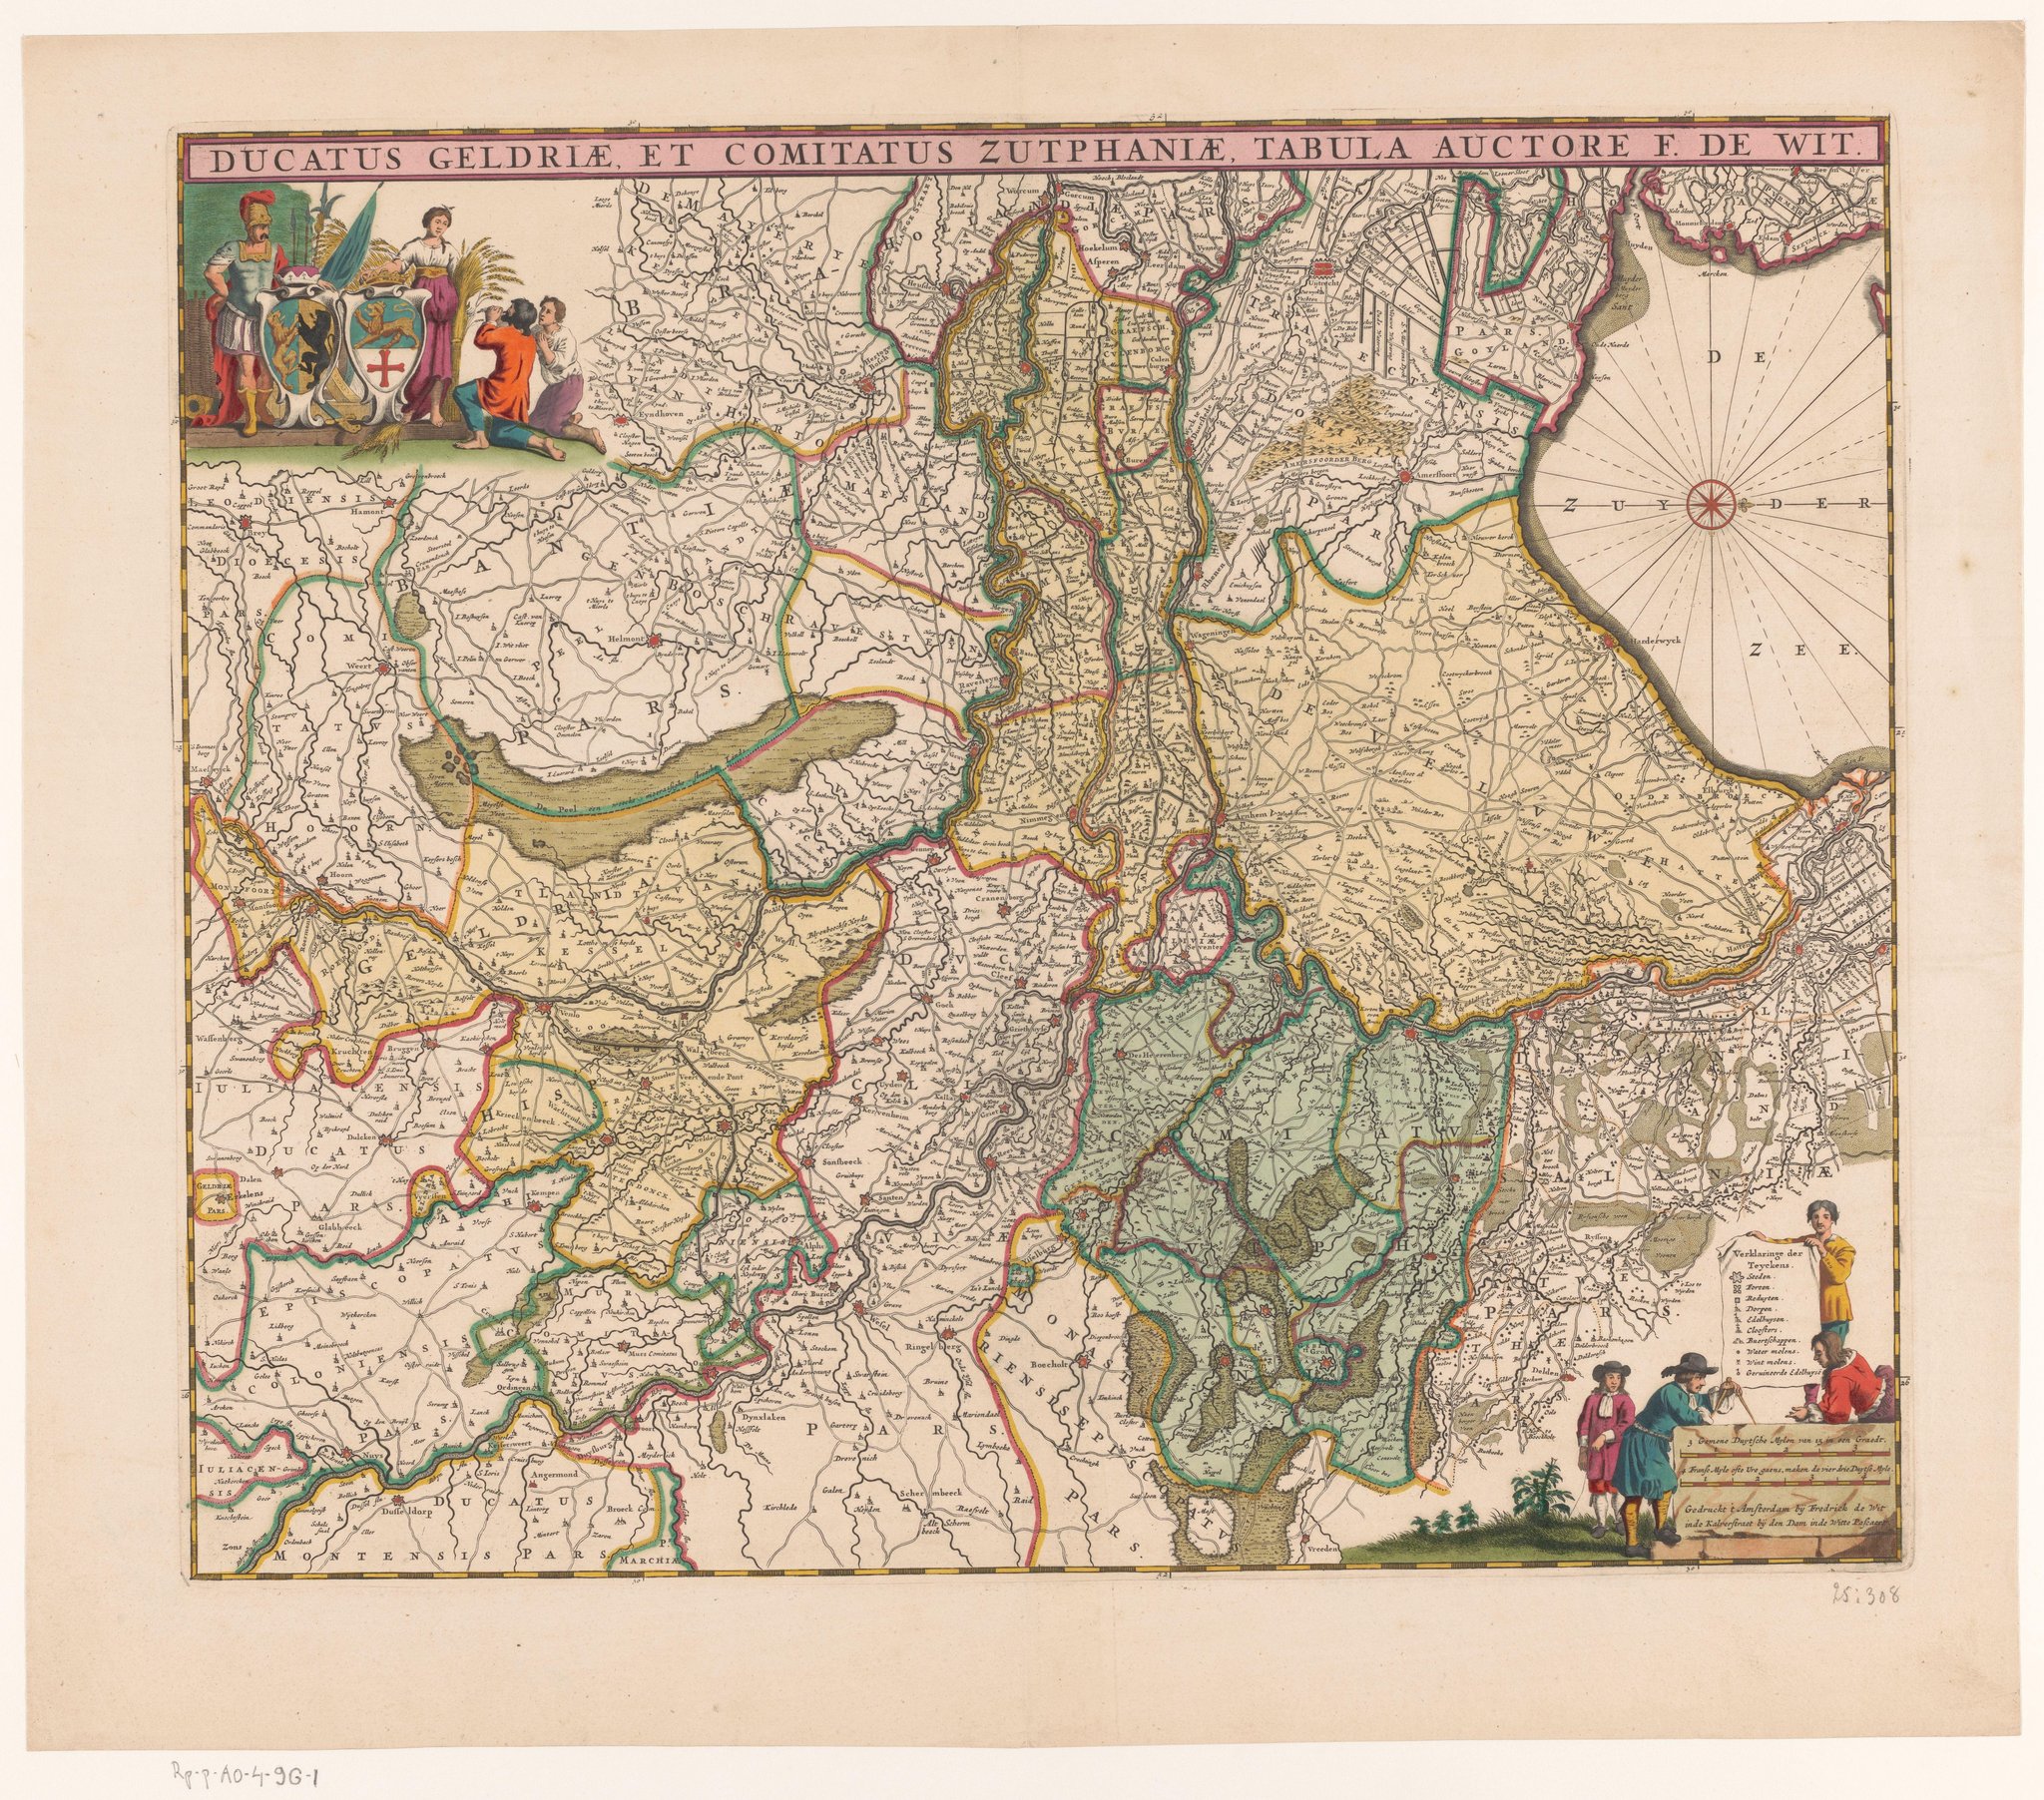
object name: map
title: Ducatus Geldriae, et comitatus Zutphaniae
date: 1667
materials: paper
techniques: engraving, etching, hand coloring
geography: amsterdam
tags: coat of arms (as symbol of the state, etc.) (+ city; municipal), maps of separate countries or regions, coat of arms (as symbol of the state, etc.) (+ province; provincial), gelderland, guelders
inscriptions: collector's mark: Lugt 2228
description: De titel in een balk boven de kaart. Linksboven de wapens van Gelre en de stad Zutphen. Rechtsonder een legenda en een cartouche met twee schaalstokken: 3 Gemene Duytsche Mylen van 15 in een Graedt / 4 Franse Myle ofte Ure gaens, maken de vier drie Duytse Myle. De kaart is voorzien van een gradenverdeling langs de randen.